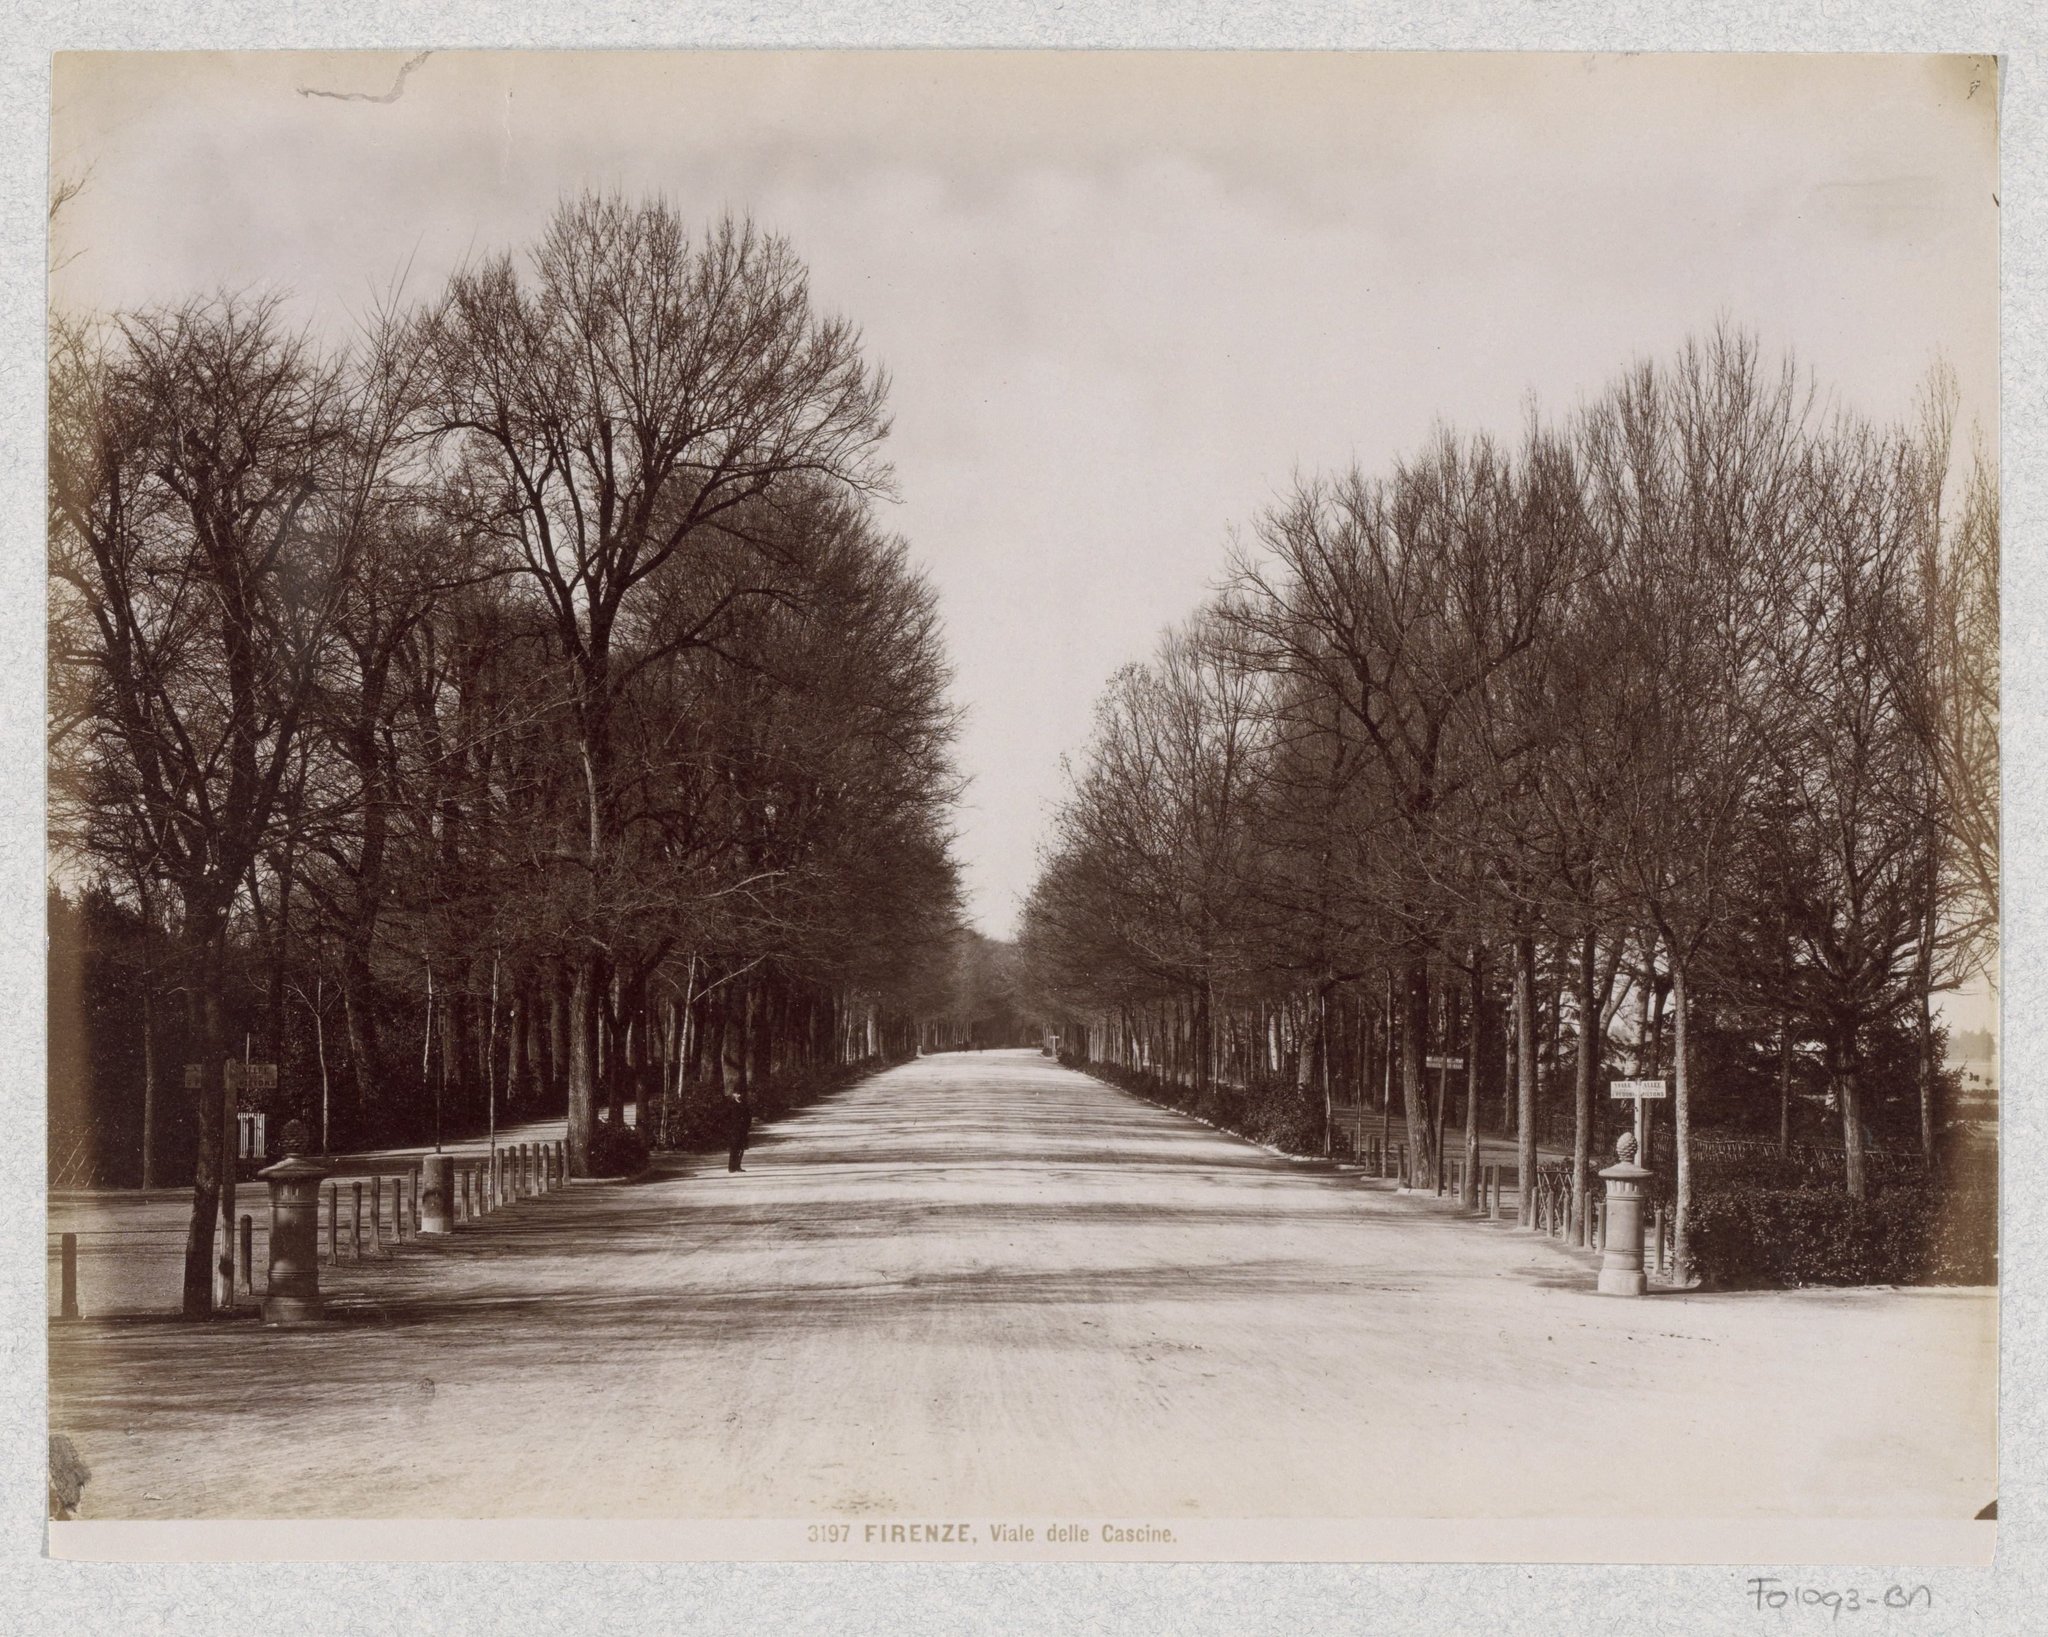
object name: photograph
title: Viale delle Cascine in Florence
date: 1870-1890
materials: paper, photographic support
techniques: albumen print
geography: florence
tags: forest path or lane, public gardens, park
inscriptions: negative number: ‘3197’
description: Onderdeel van Reisalbum met foto's van bezienswaardigheden in Genua, Florence en Venetië.